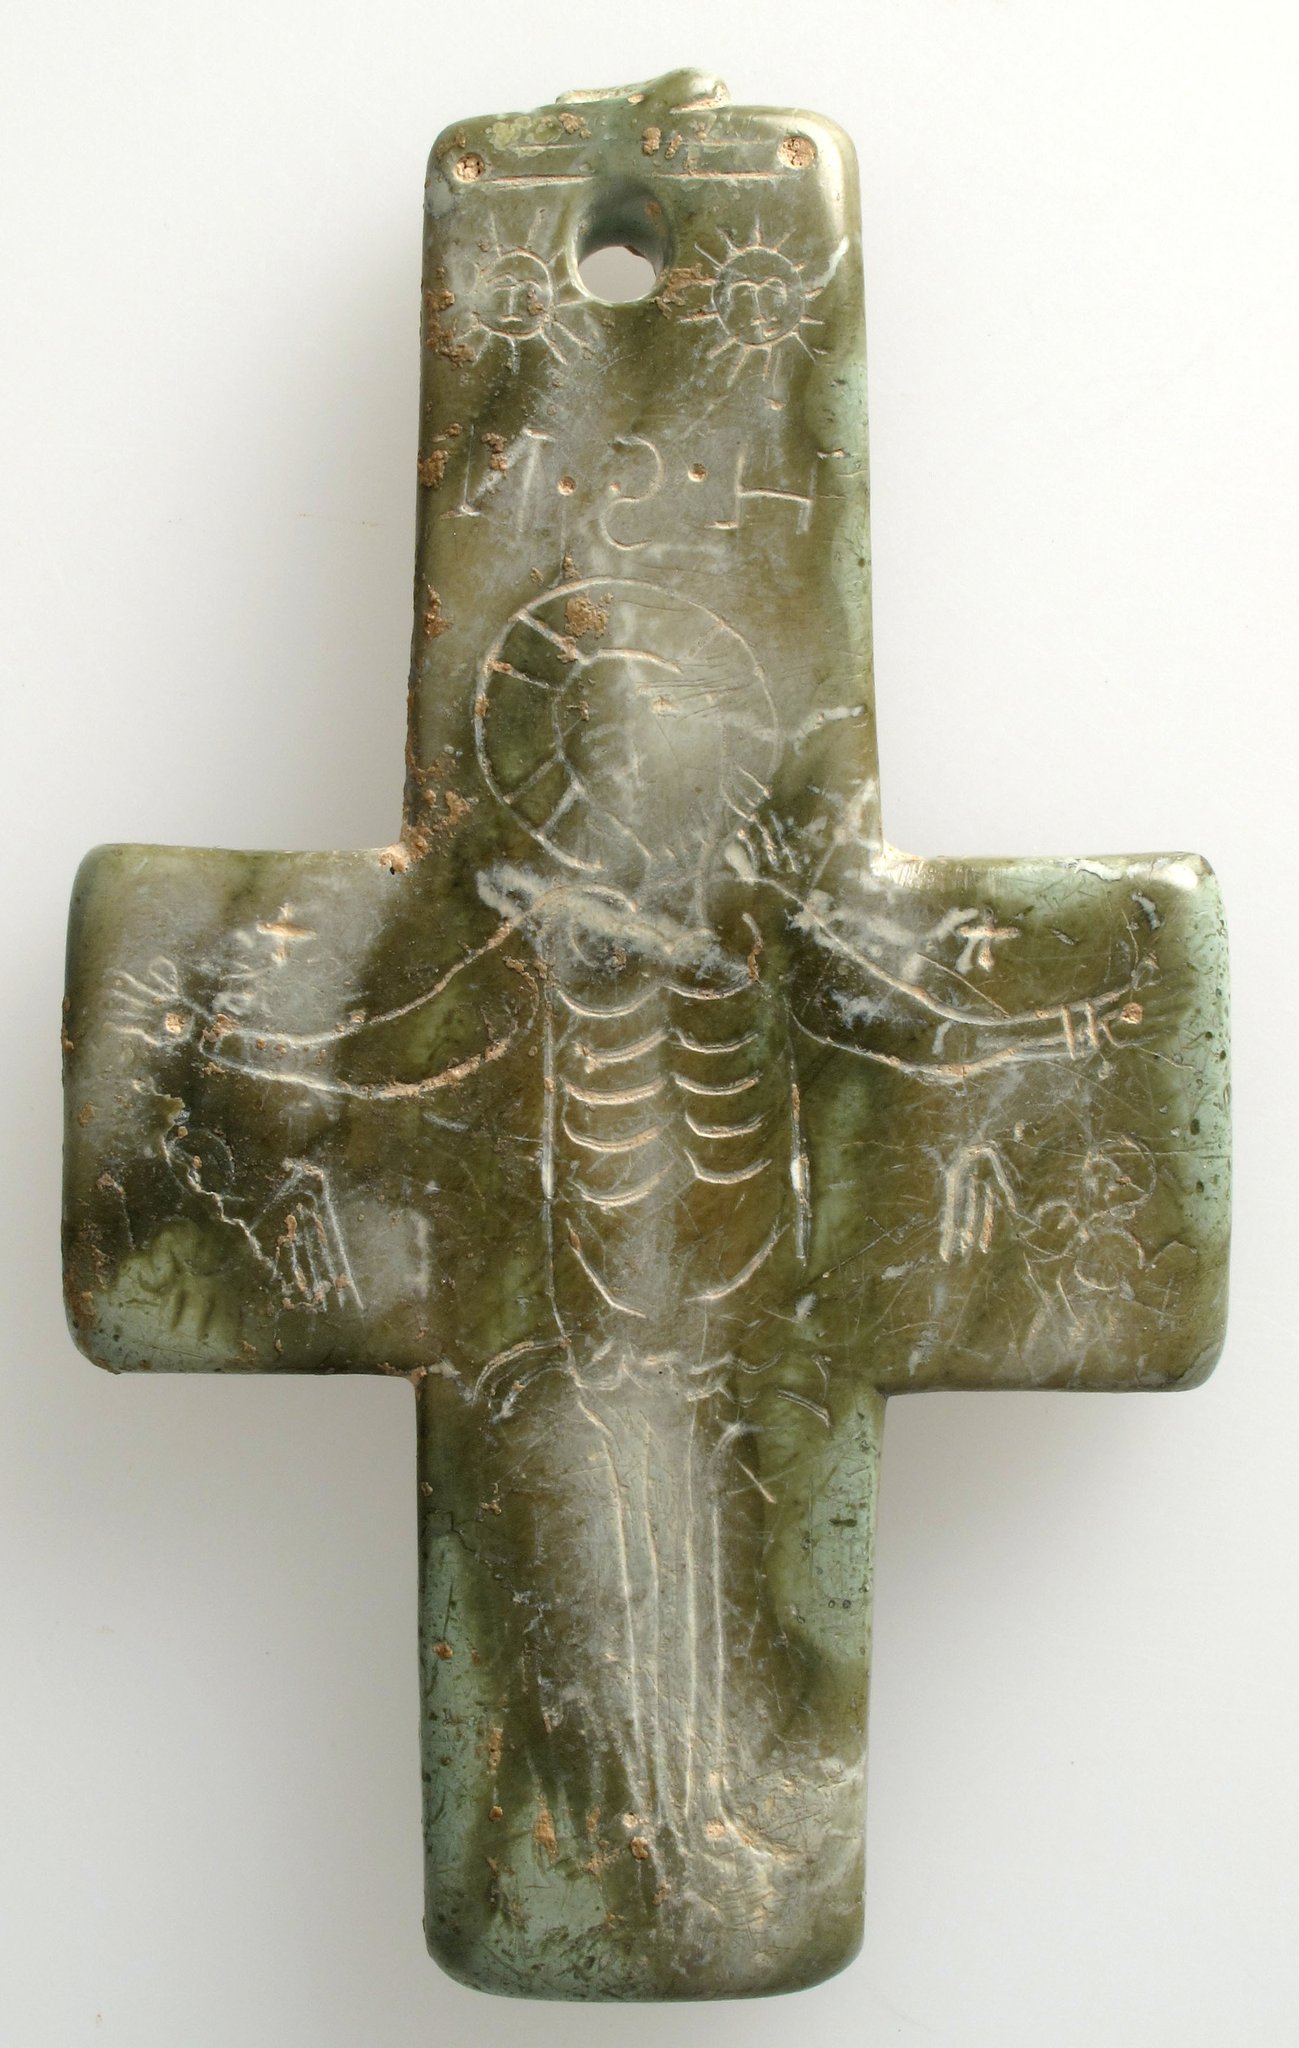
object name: cross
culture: byzantine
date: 1001-1100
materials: stone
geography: syria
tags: christ,cross